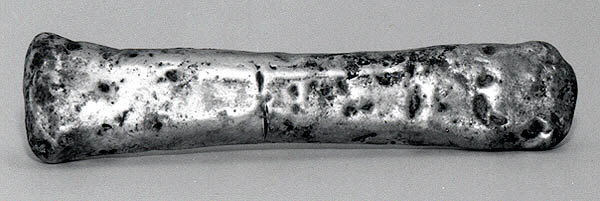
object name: ingot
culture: iranian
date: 700-501 BCE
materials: silver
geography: iran